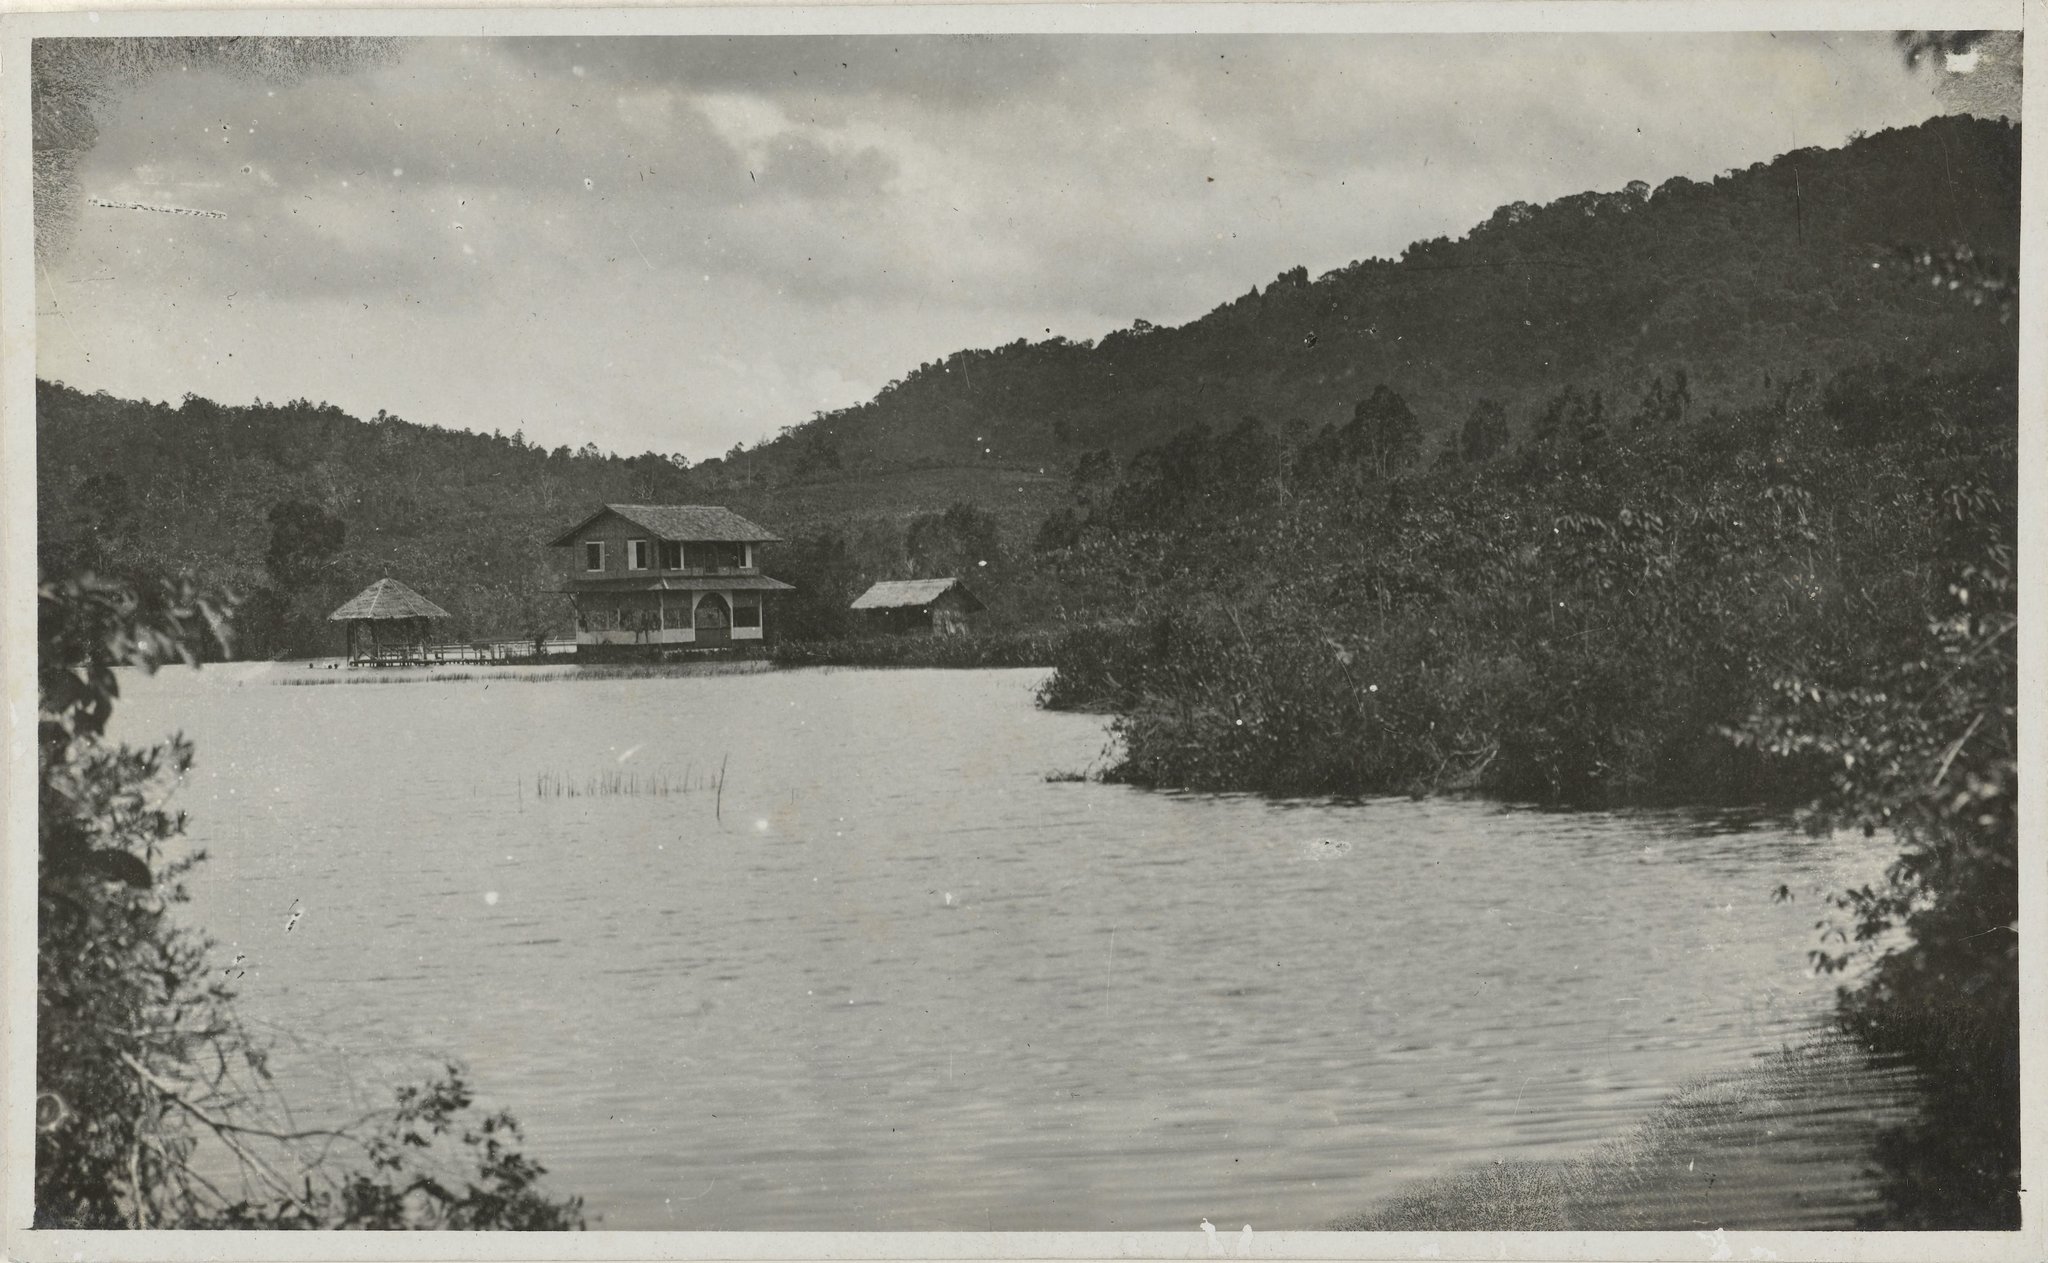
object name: ansichtkaart, prentbriefkaart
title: Riviergezicht met uitzicht op een woning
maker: Anonymous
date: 1920-1940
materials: photographic support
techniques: gelatin silver print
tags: indonesia